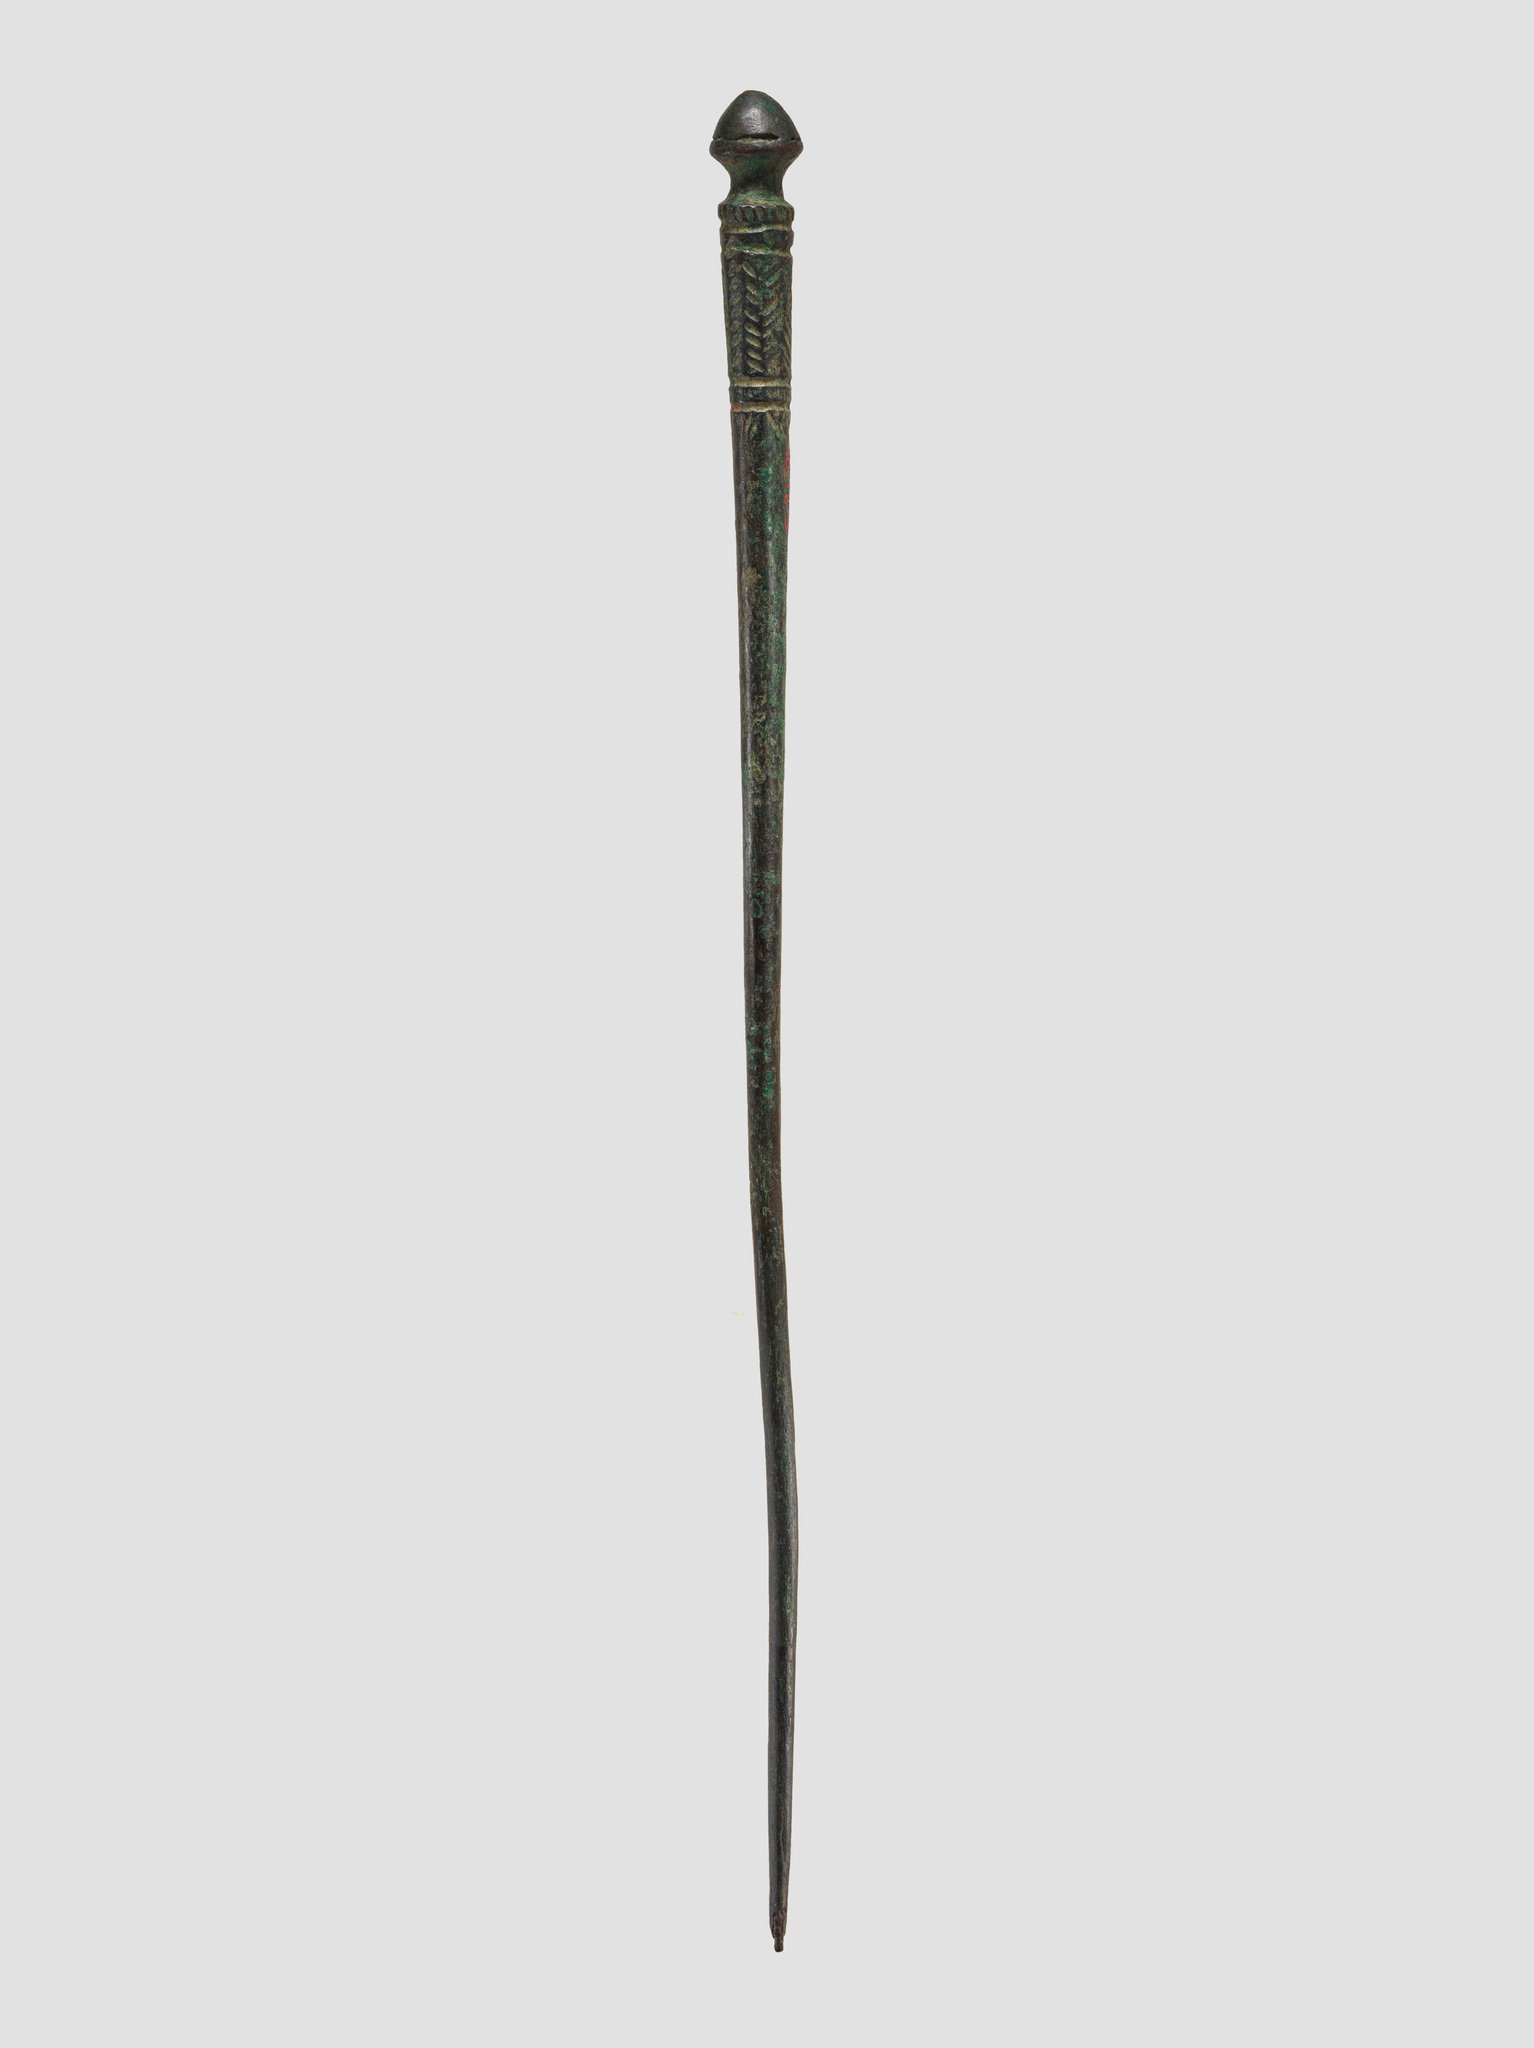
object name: pin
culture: iranian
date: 1000-668 BCE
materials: bronze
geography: iran, probably from luristan